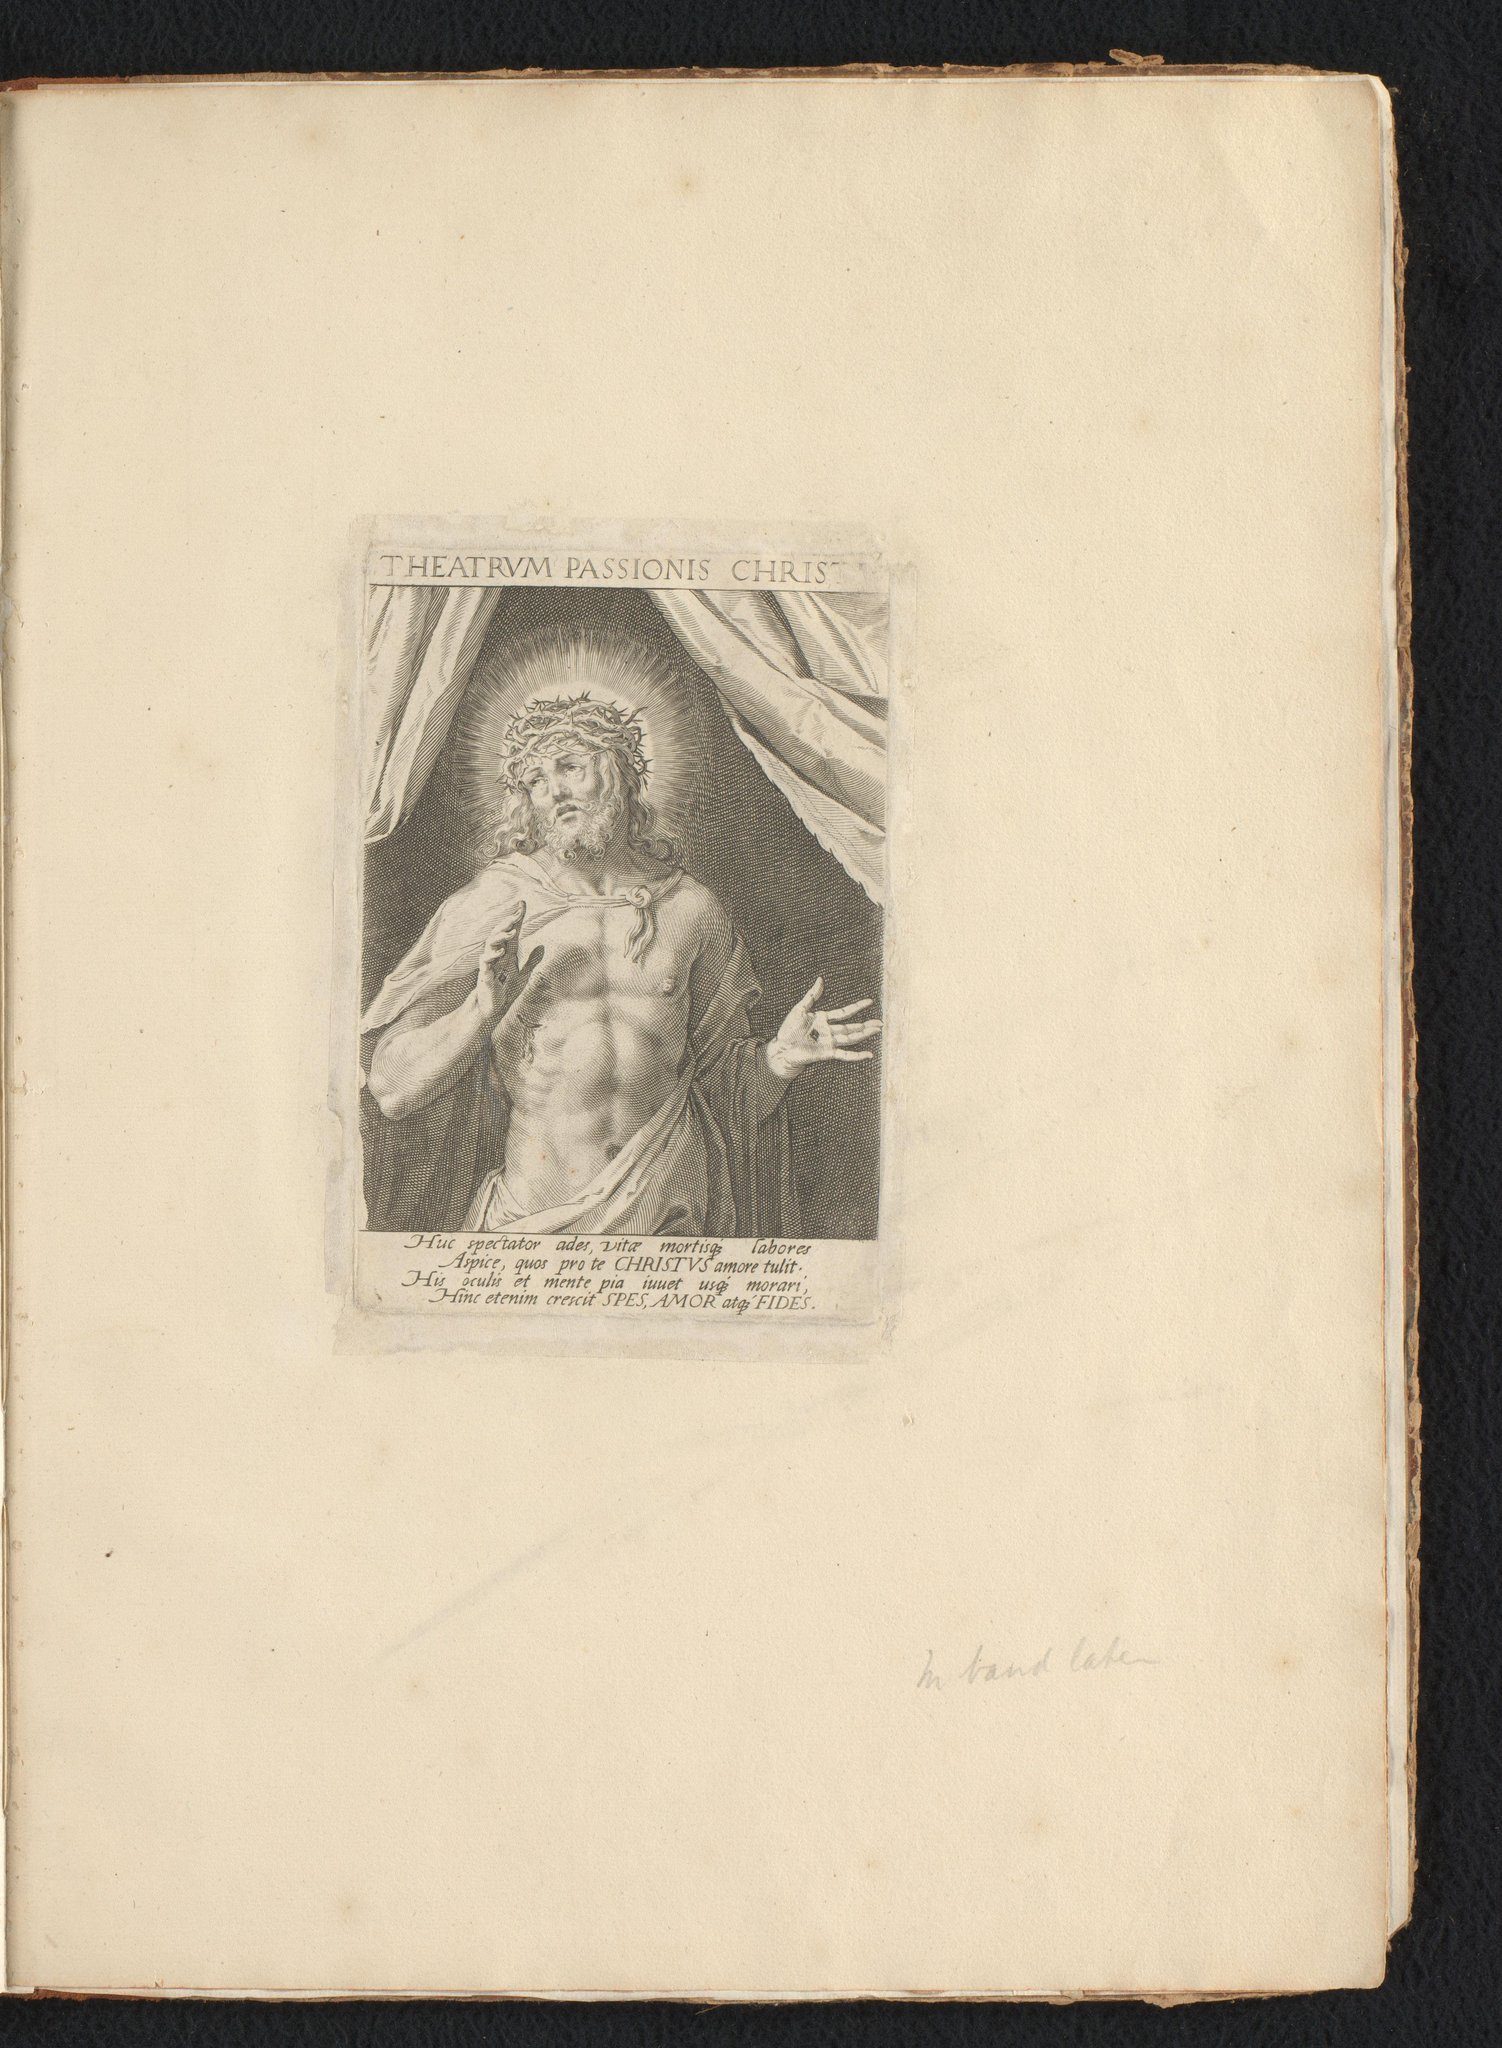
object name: album leaf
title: Man van Smarten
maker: aegidius sadeler (ii)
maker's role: draughtsman, print maker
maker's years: 1568-1629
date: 1580-1629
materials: paper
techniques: engraving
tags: man of sorrows, 'imago pietatis', 'erbärmdebild', 'schmerzensmann'; the upright christ showing his wounds, usually bearing the crown of thorns, and accompanied by the instruments of the passion, standing or sitting in his tomb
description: Christus als man van smarten, met een doornenkroon op het hoofd. Titelprent van serie van prenten met de passiewerktuigen als onderwerp. De prent heeft een onderschrift in het Latijn. Deze prent maakt deel uit van een album.